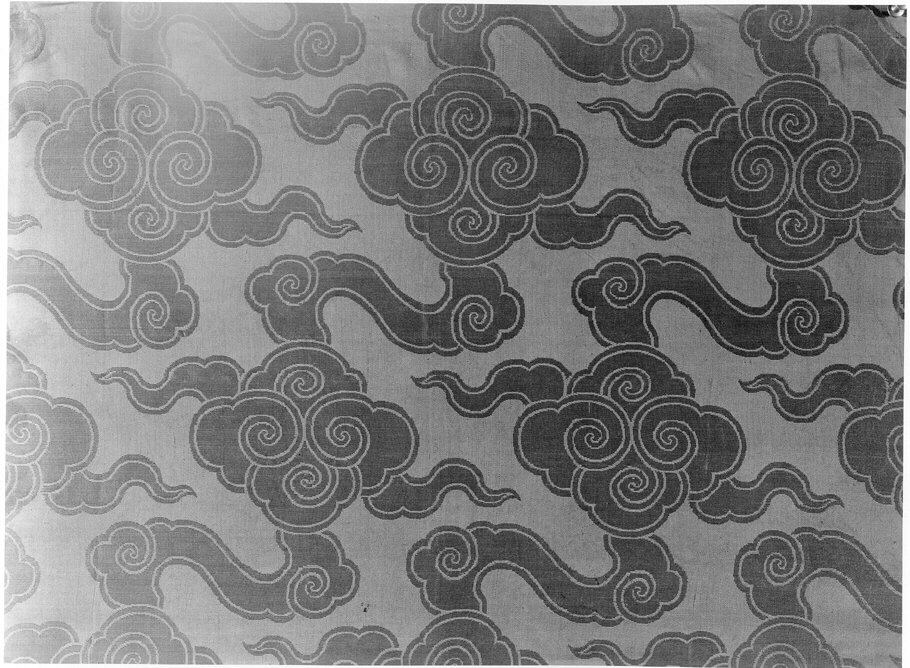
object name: piece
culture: chinese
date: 1701-1800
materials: silk